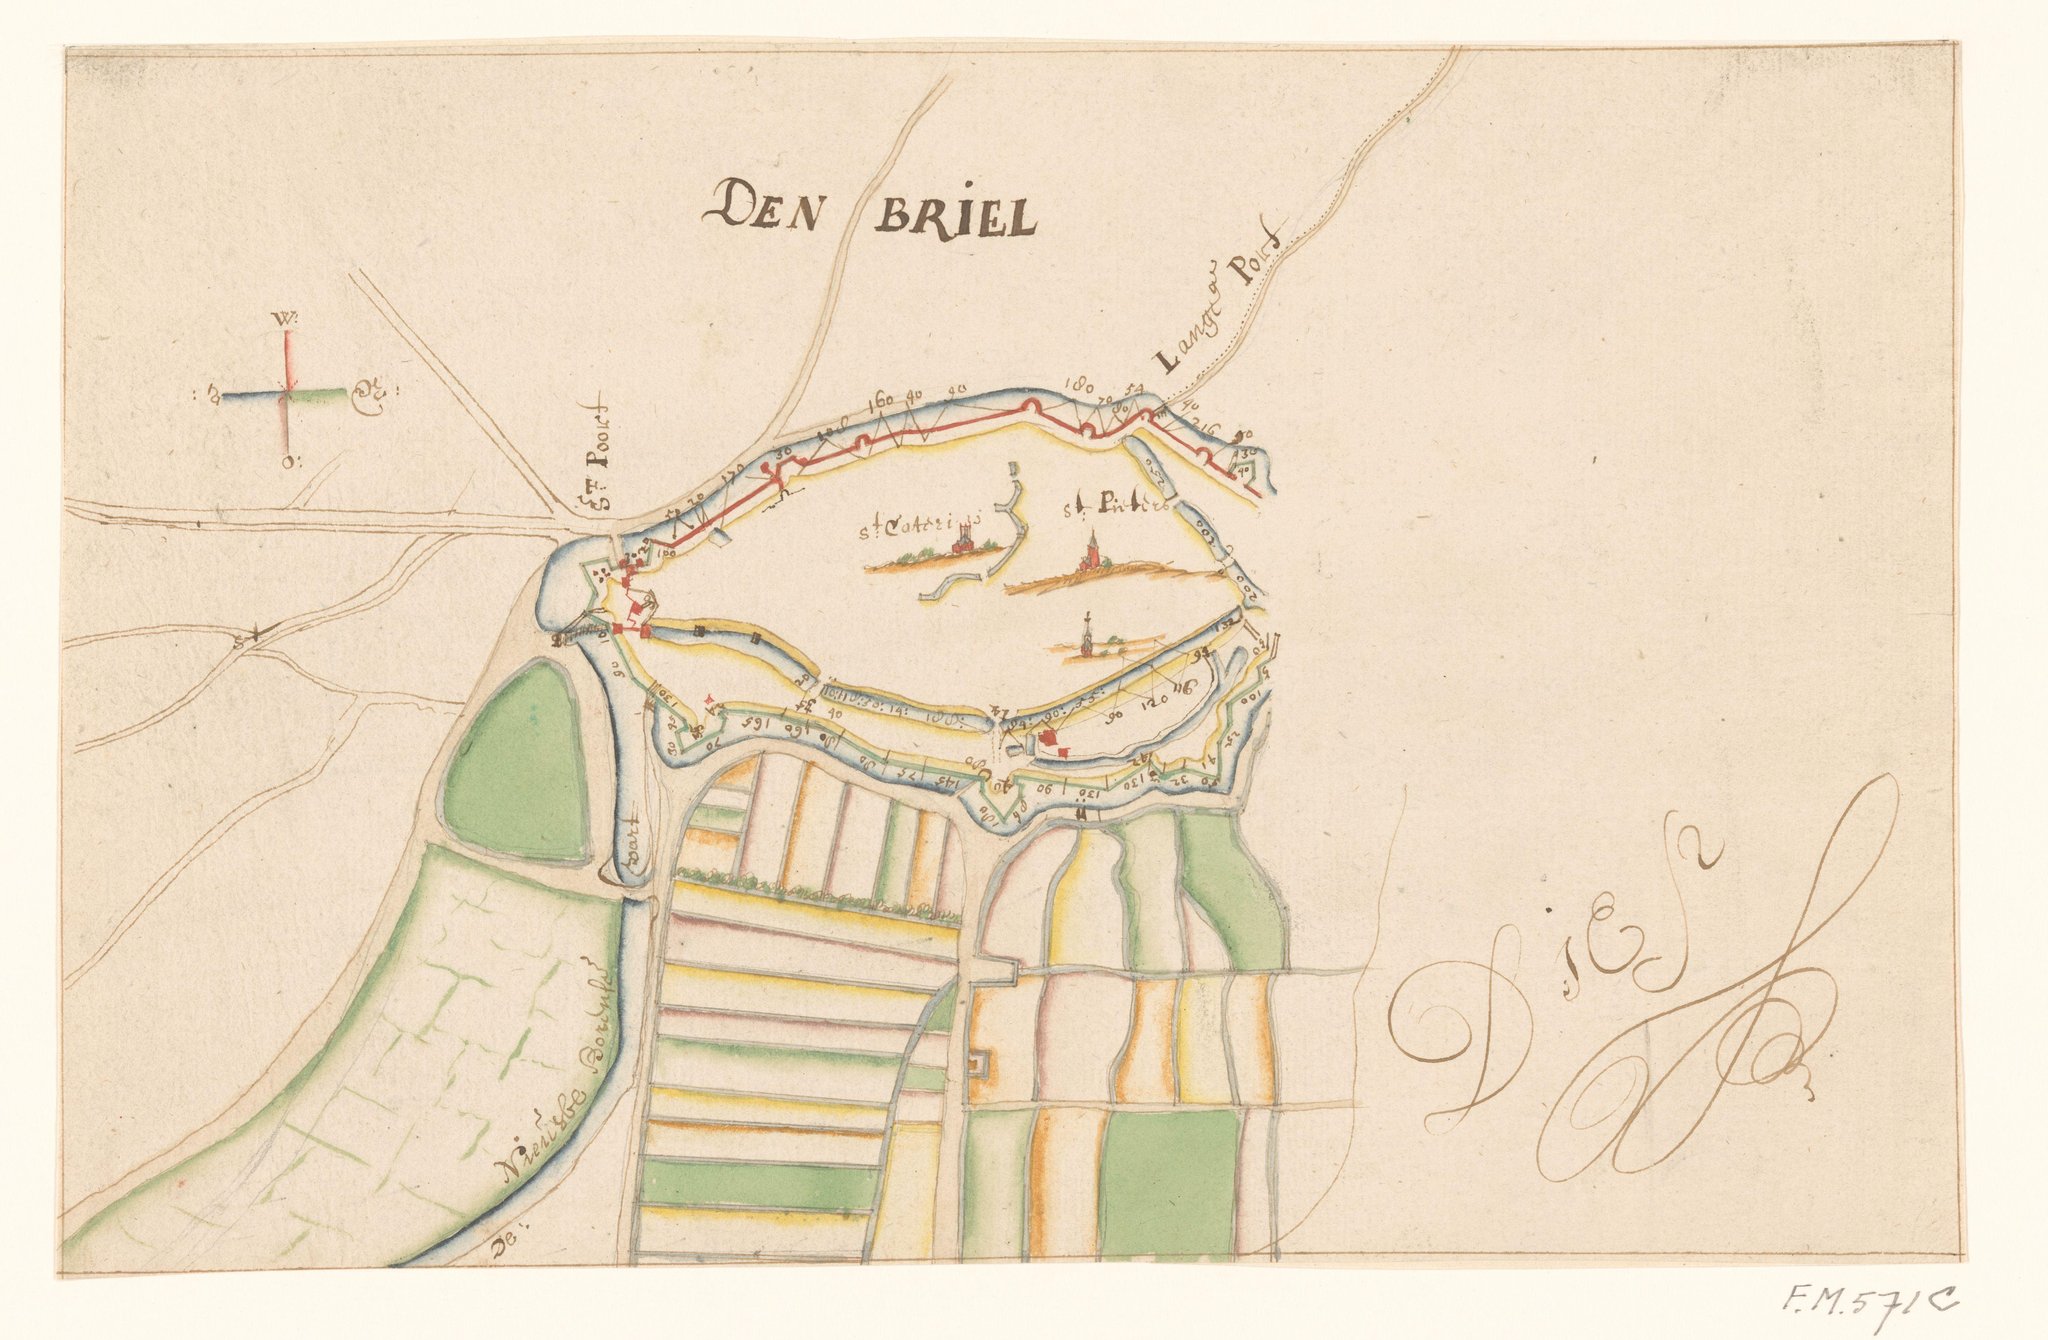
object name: area plan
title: Den Briel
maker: Anonymous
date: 1675-1725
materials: ink, paper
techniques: brush, pen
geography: netherlands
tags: fortifications, military engineering, maps of cities, brielle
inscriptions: collector's mark: Lugt 2228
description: Plan van Den Briel met het omliggende land ten oosten van de stad en De Nieuwe Horense Vaart. Op de kaart zijn om de stad de waterwegen, grachten, singels en stadspoorten aangegeven, binnen de stad alleen drie kerken en een gracht. In de stadswallen zijn cijfers gezet. Wellicht een ingenieurstekening. Rechts een gekalligrafeerde signatuur.